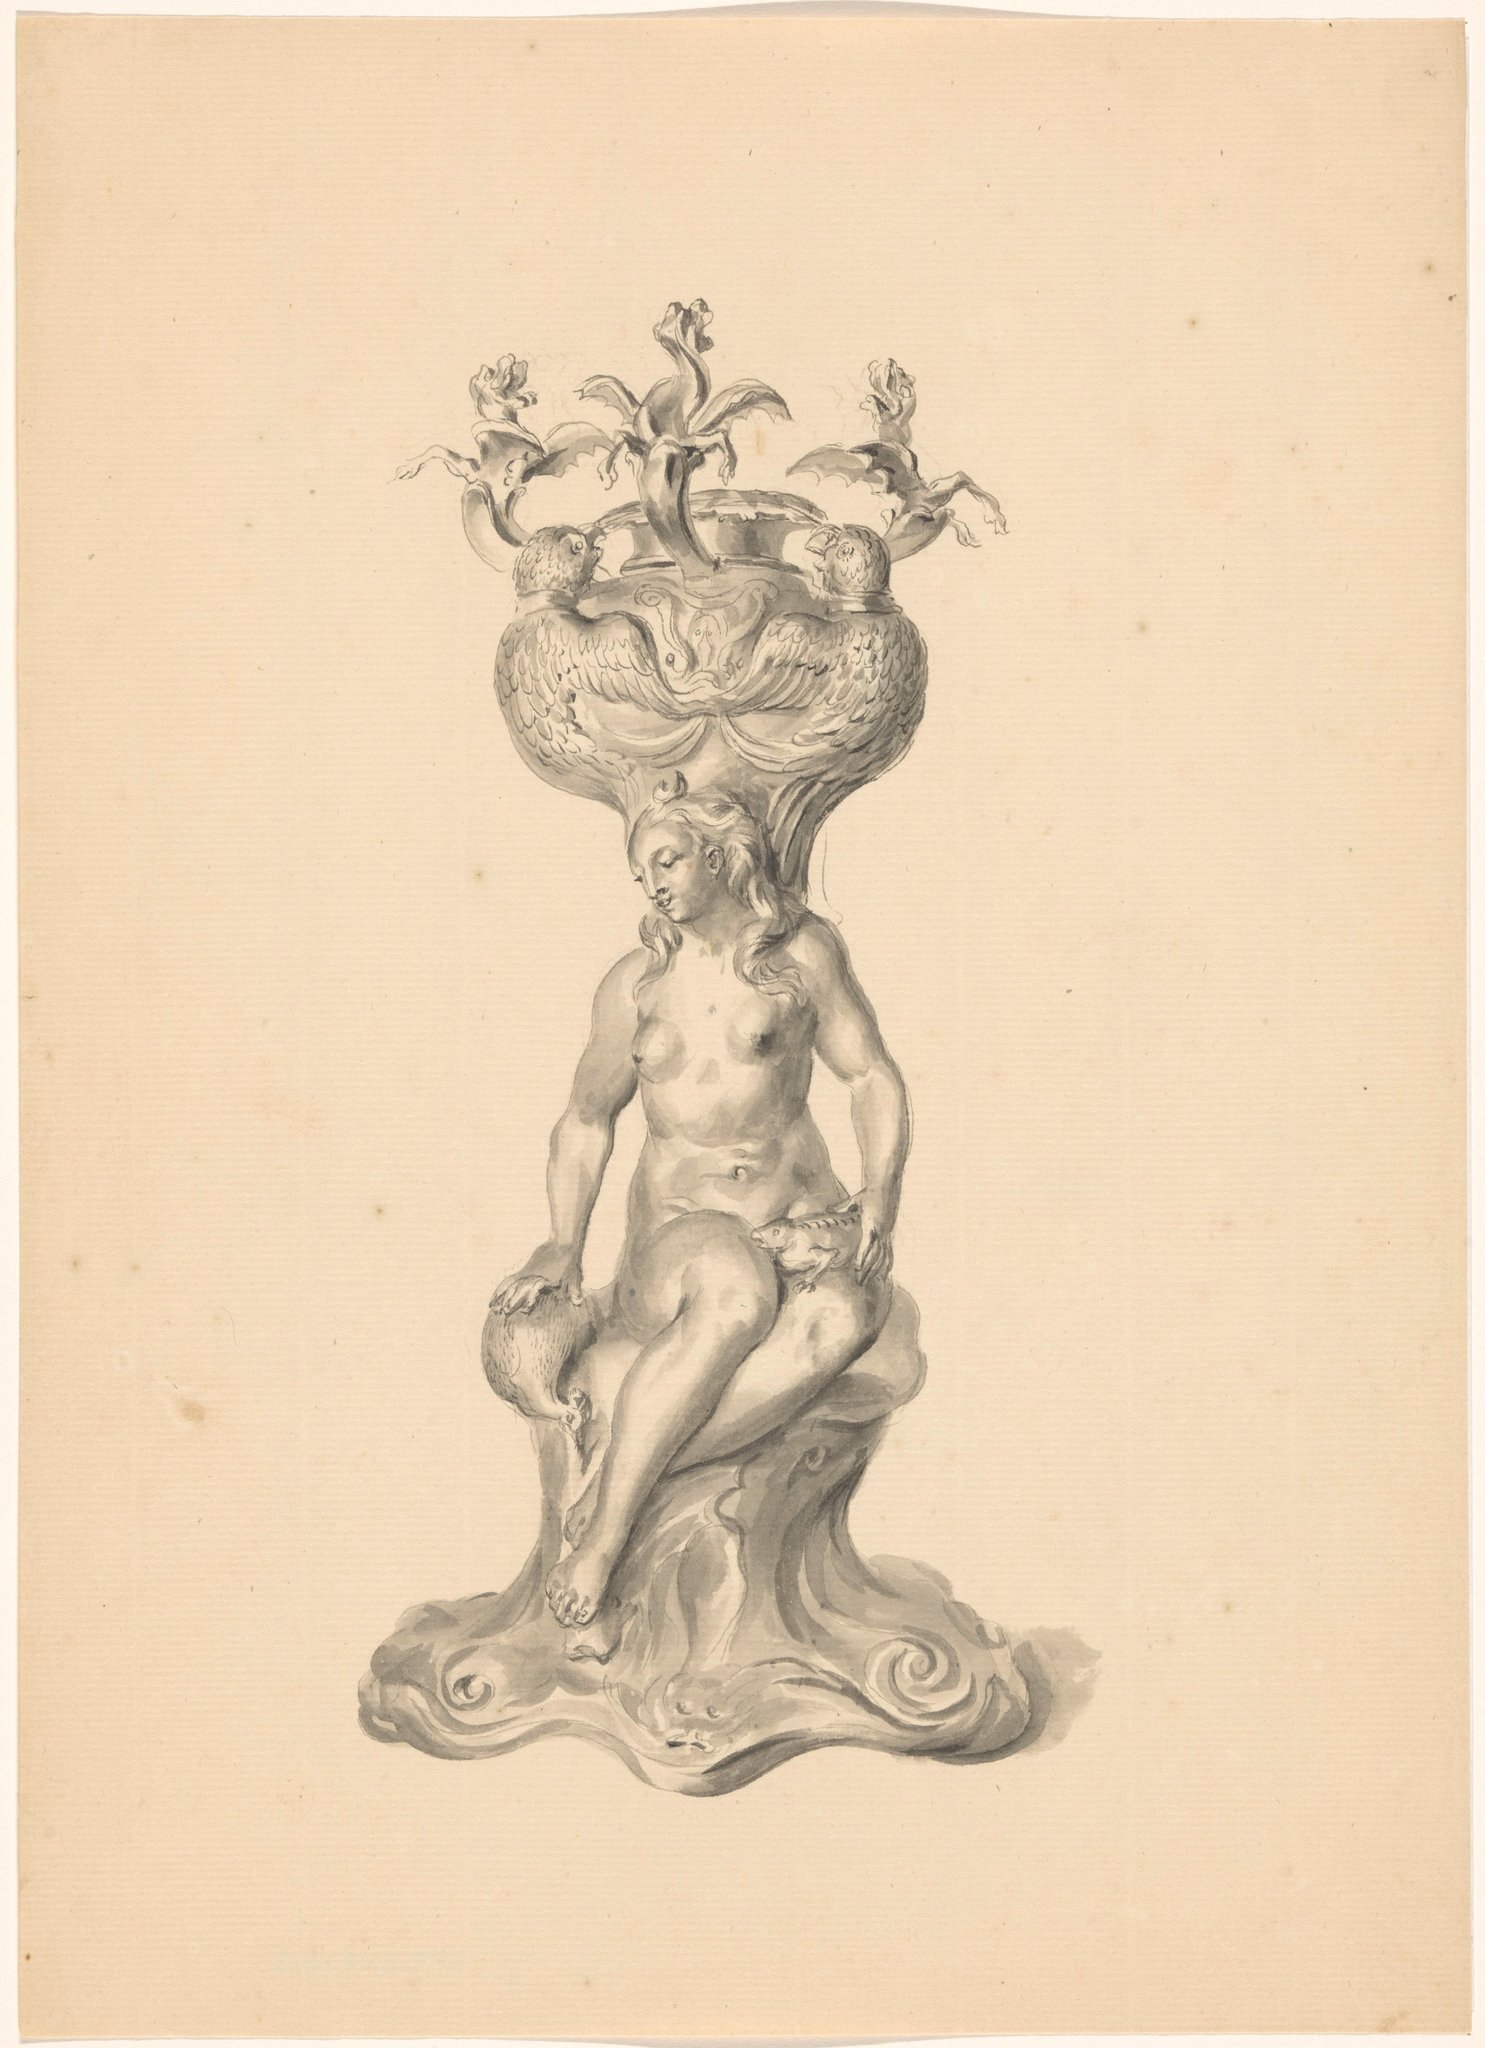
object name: album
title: Tekening van 17e eeuws zilver behorende bij een album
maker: Anonymous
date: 1725-1728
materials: paper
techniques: drawing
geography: amsterdam